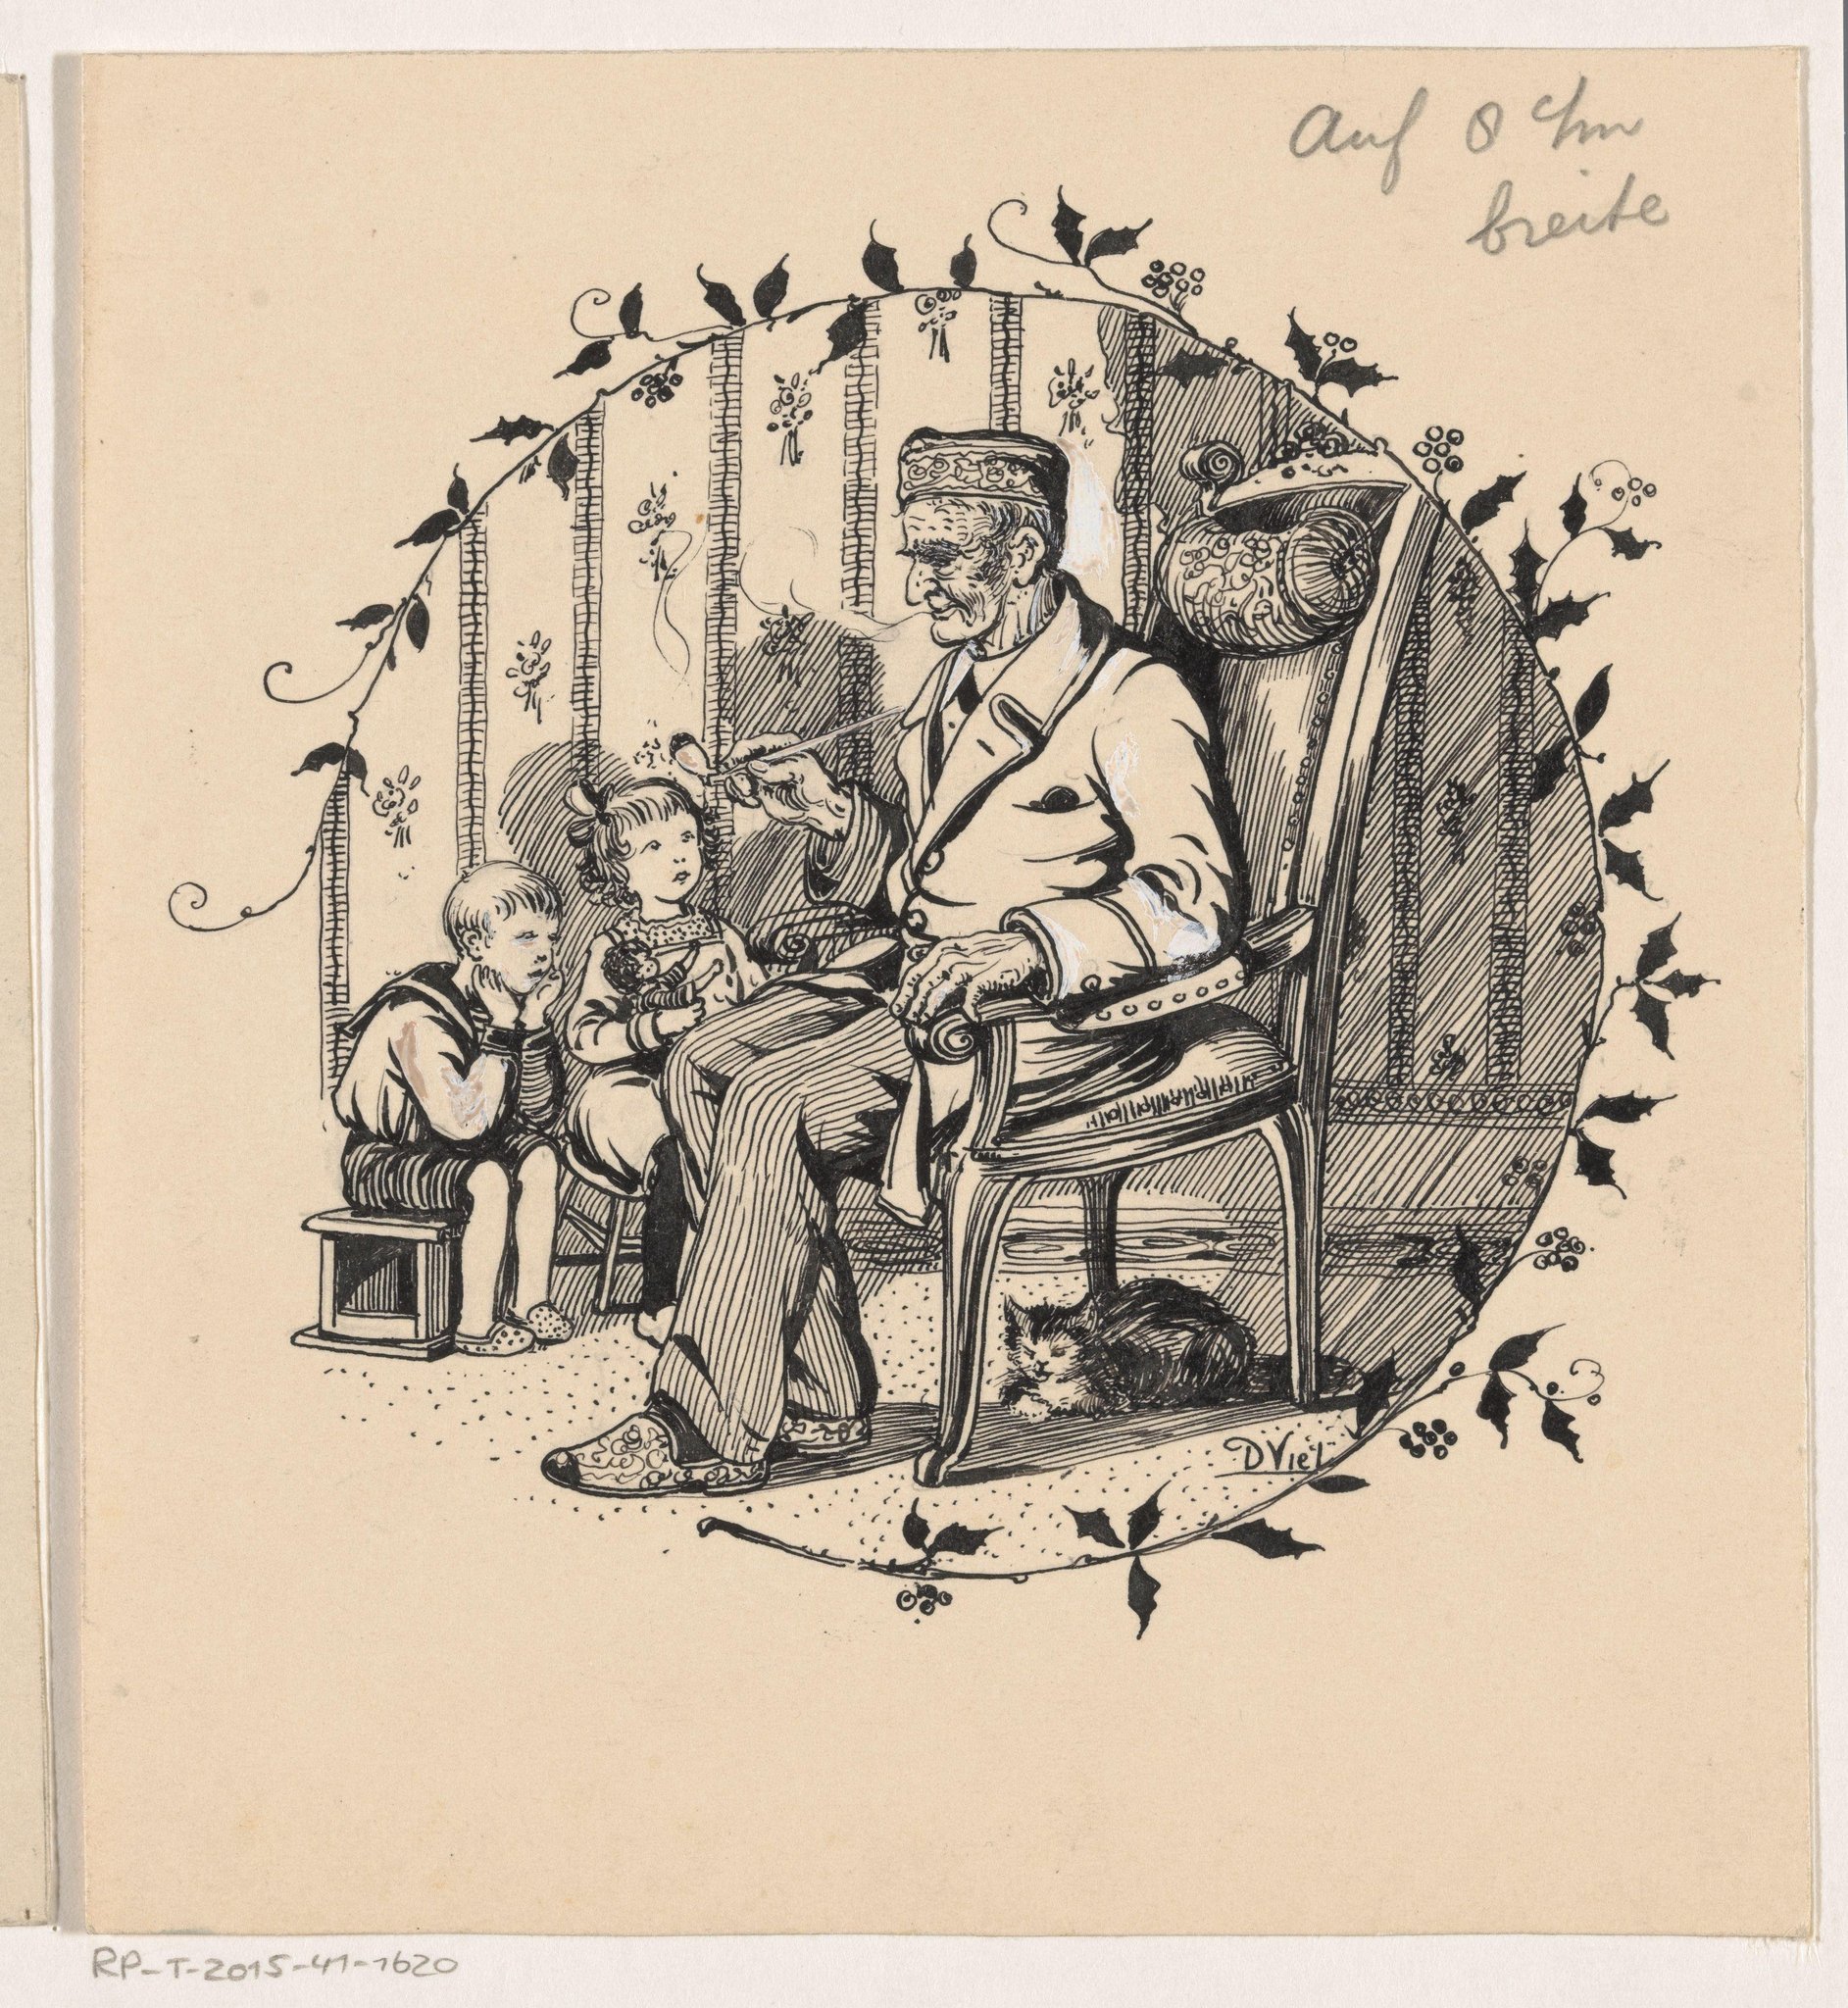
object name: boekillustratie ontwerp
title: Pijprokende man en twee kinderen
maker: d. viel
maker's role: draughtsman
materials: paint, ink, paper, pencil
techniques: brush, pen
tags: cat, pipe ~ tobacco, sitting figure (+ old male (human being))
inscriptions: :, collector's mark: Lugt 2228, signature: ‘D. Viel’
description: In een interieur zit een oude man in een leunstoel een pijp te roken. Een jongen en een meisje zitten elk op een kruk naast hem. Onder de stoel van de man ligt een kat.